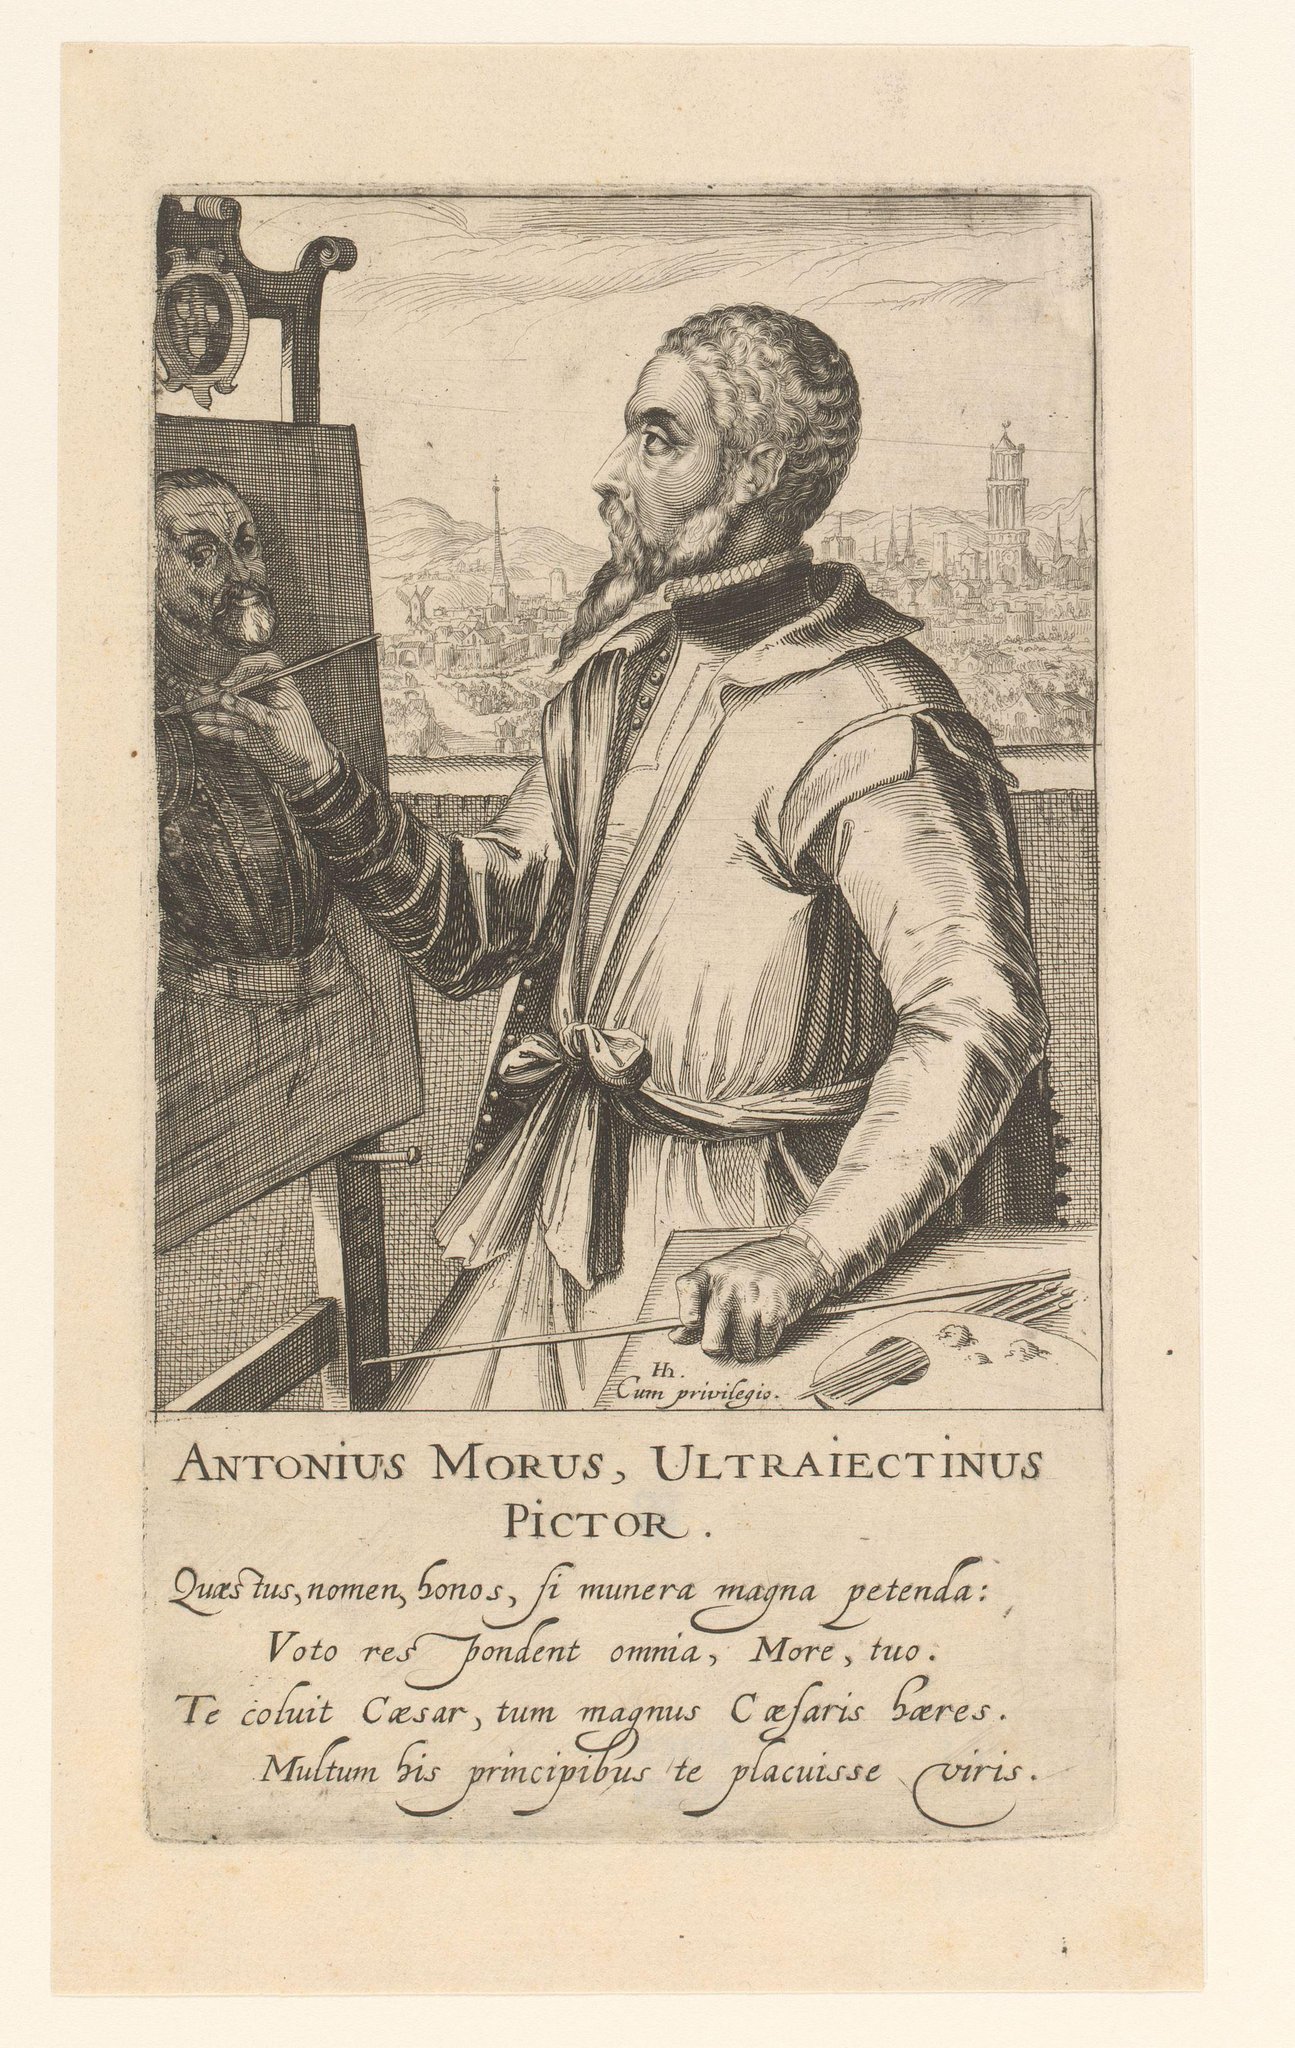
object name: print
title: Antonius Morus, Ultraiectinus Pictor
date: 1610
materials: paper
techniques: engraving, etching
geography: the hague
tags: utrecht, painter, anthonis mor, historical persons, portrait, self-portrait of painter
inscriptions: collector's mark: Lugt 2760, collector's mark: Lugt 2166